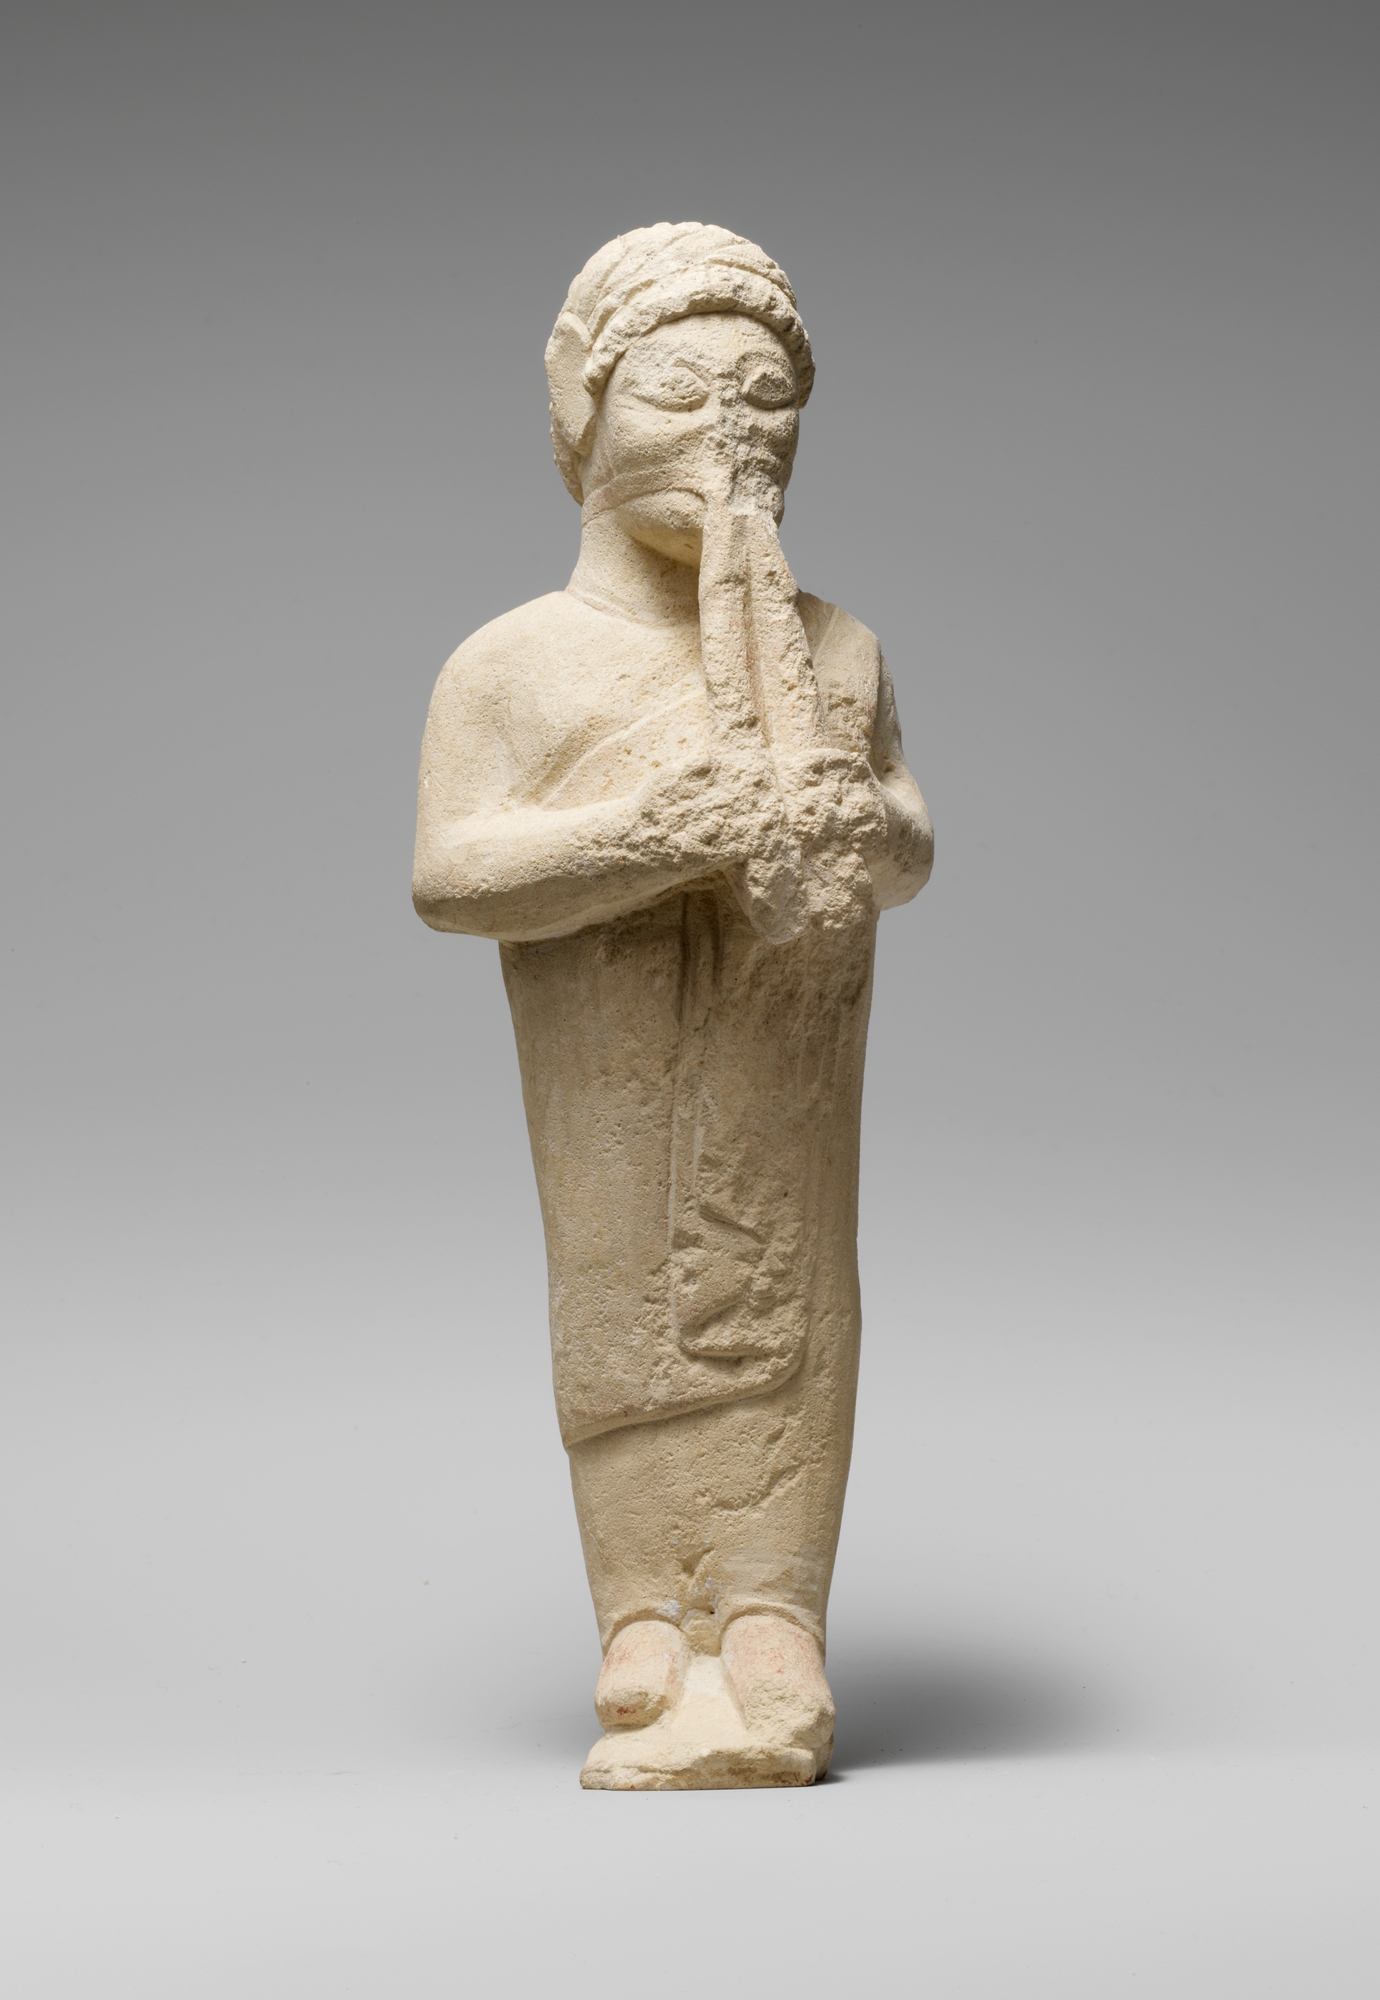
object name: statuette of a flute player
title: Limestone statuette of a flute-player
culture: cypriot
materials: limestone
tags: human figures,flutes,musicians